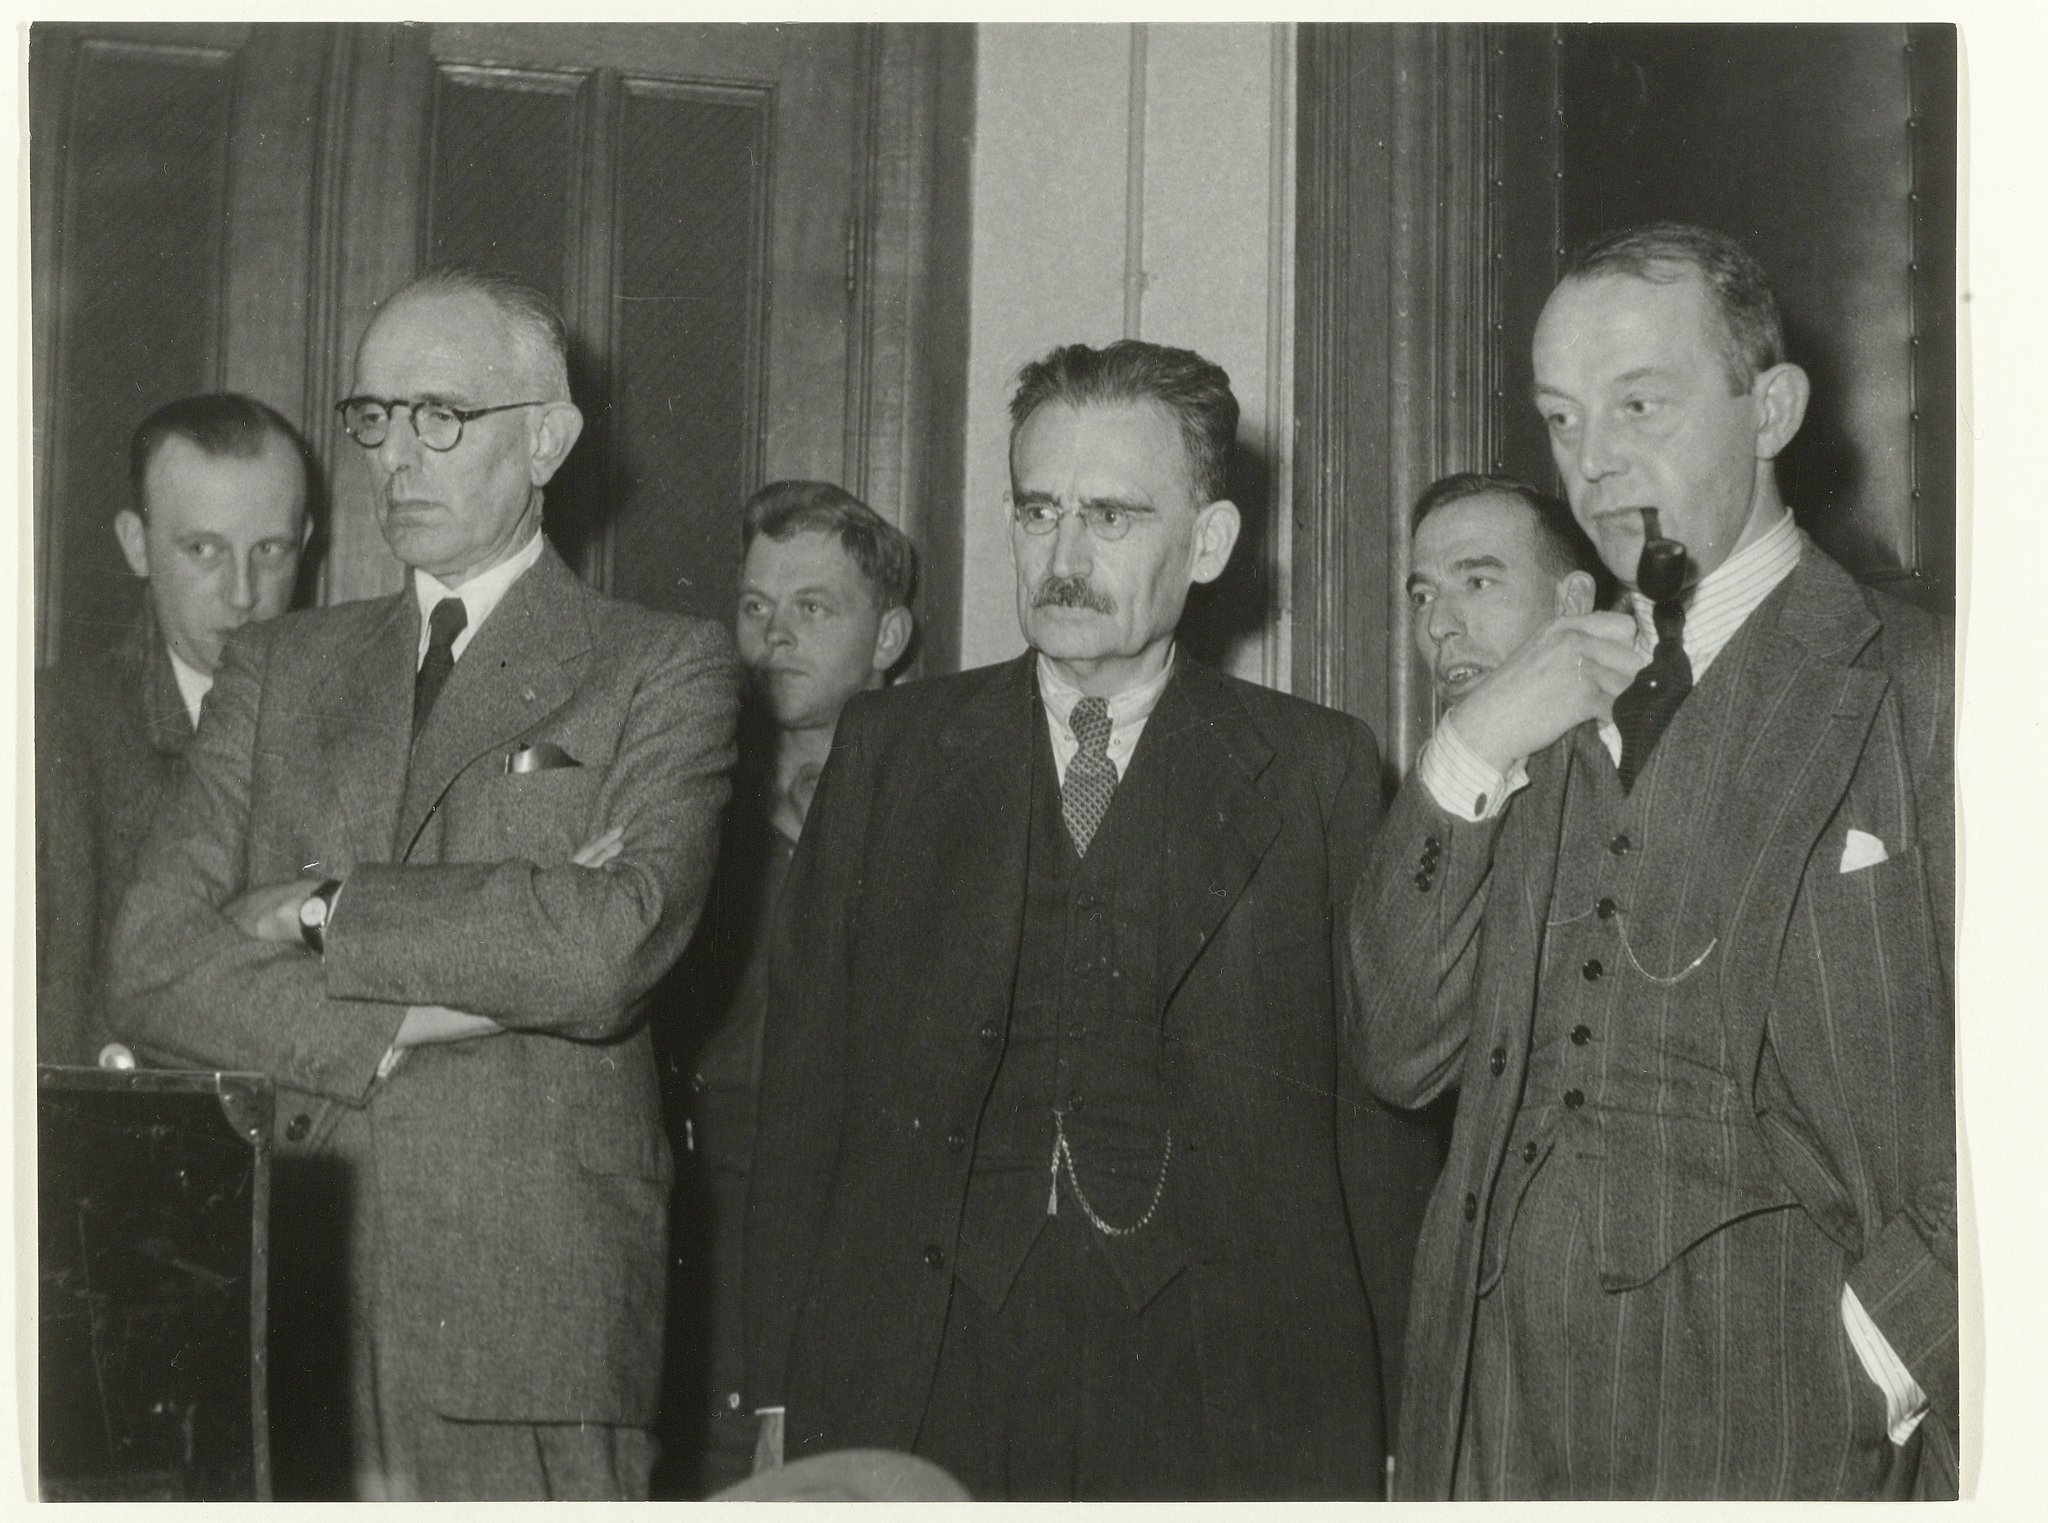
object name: documentary photograph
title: Willem Drees luistert naar radiotoespraak Schermerhorn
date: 1945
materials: photographic support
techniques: photography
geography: the hague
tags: haarlem, willem schermerhorn, the hague, willem drees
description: Willem Drees, in gezelschap van een aantal ministers luistert naar een radiotoespraak van Schermerhorn over de crisis in Indonesië.